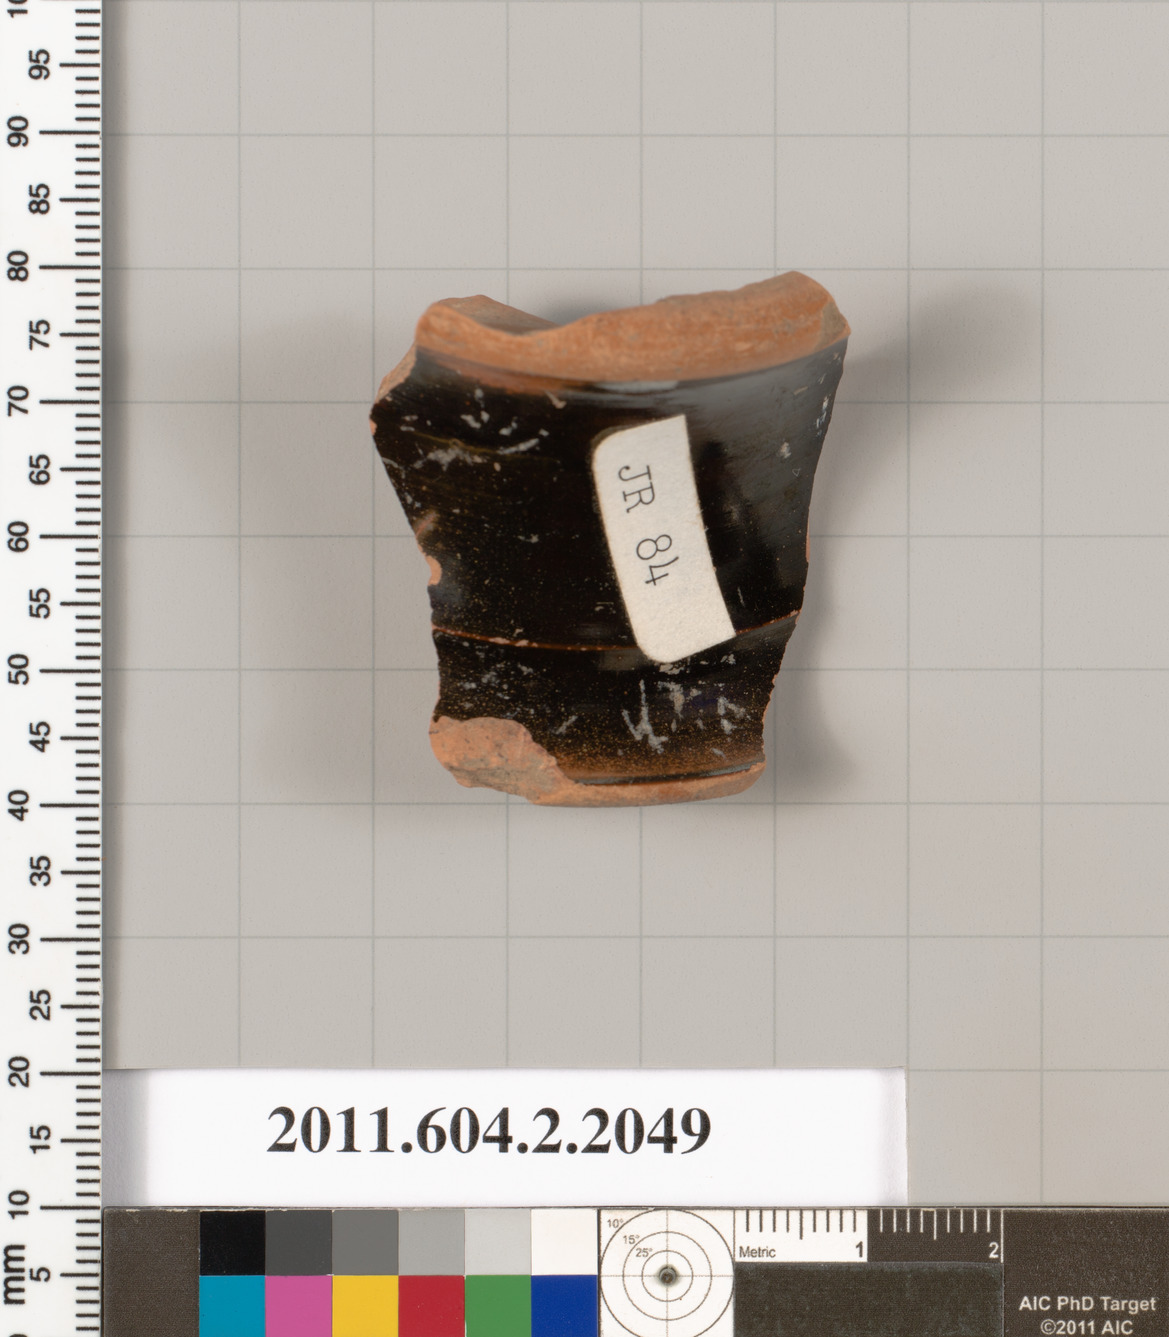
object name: salt cellar fragment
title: Terracotta fragment of a salt cellar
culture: greek, attic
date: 500 BCE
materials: terracotta